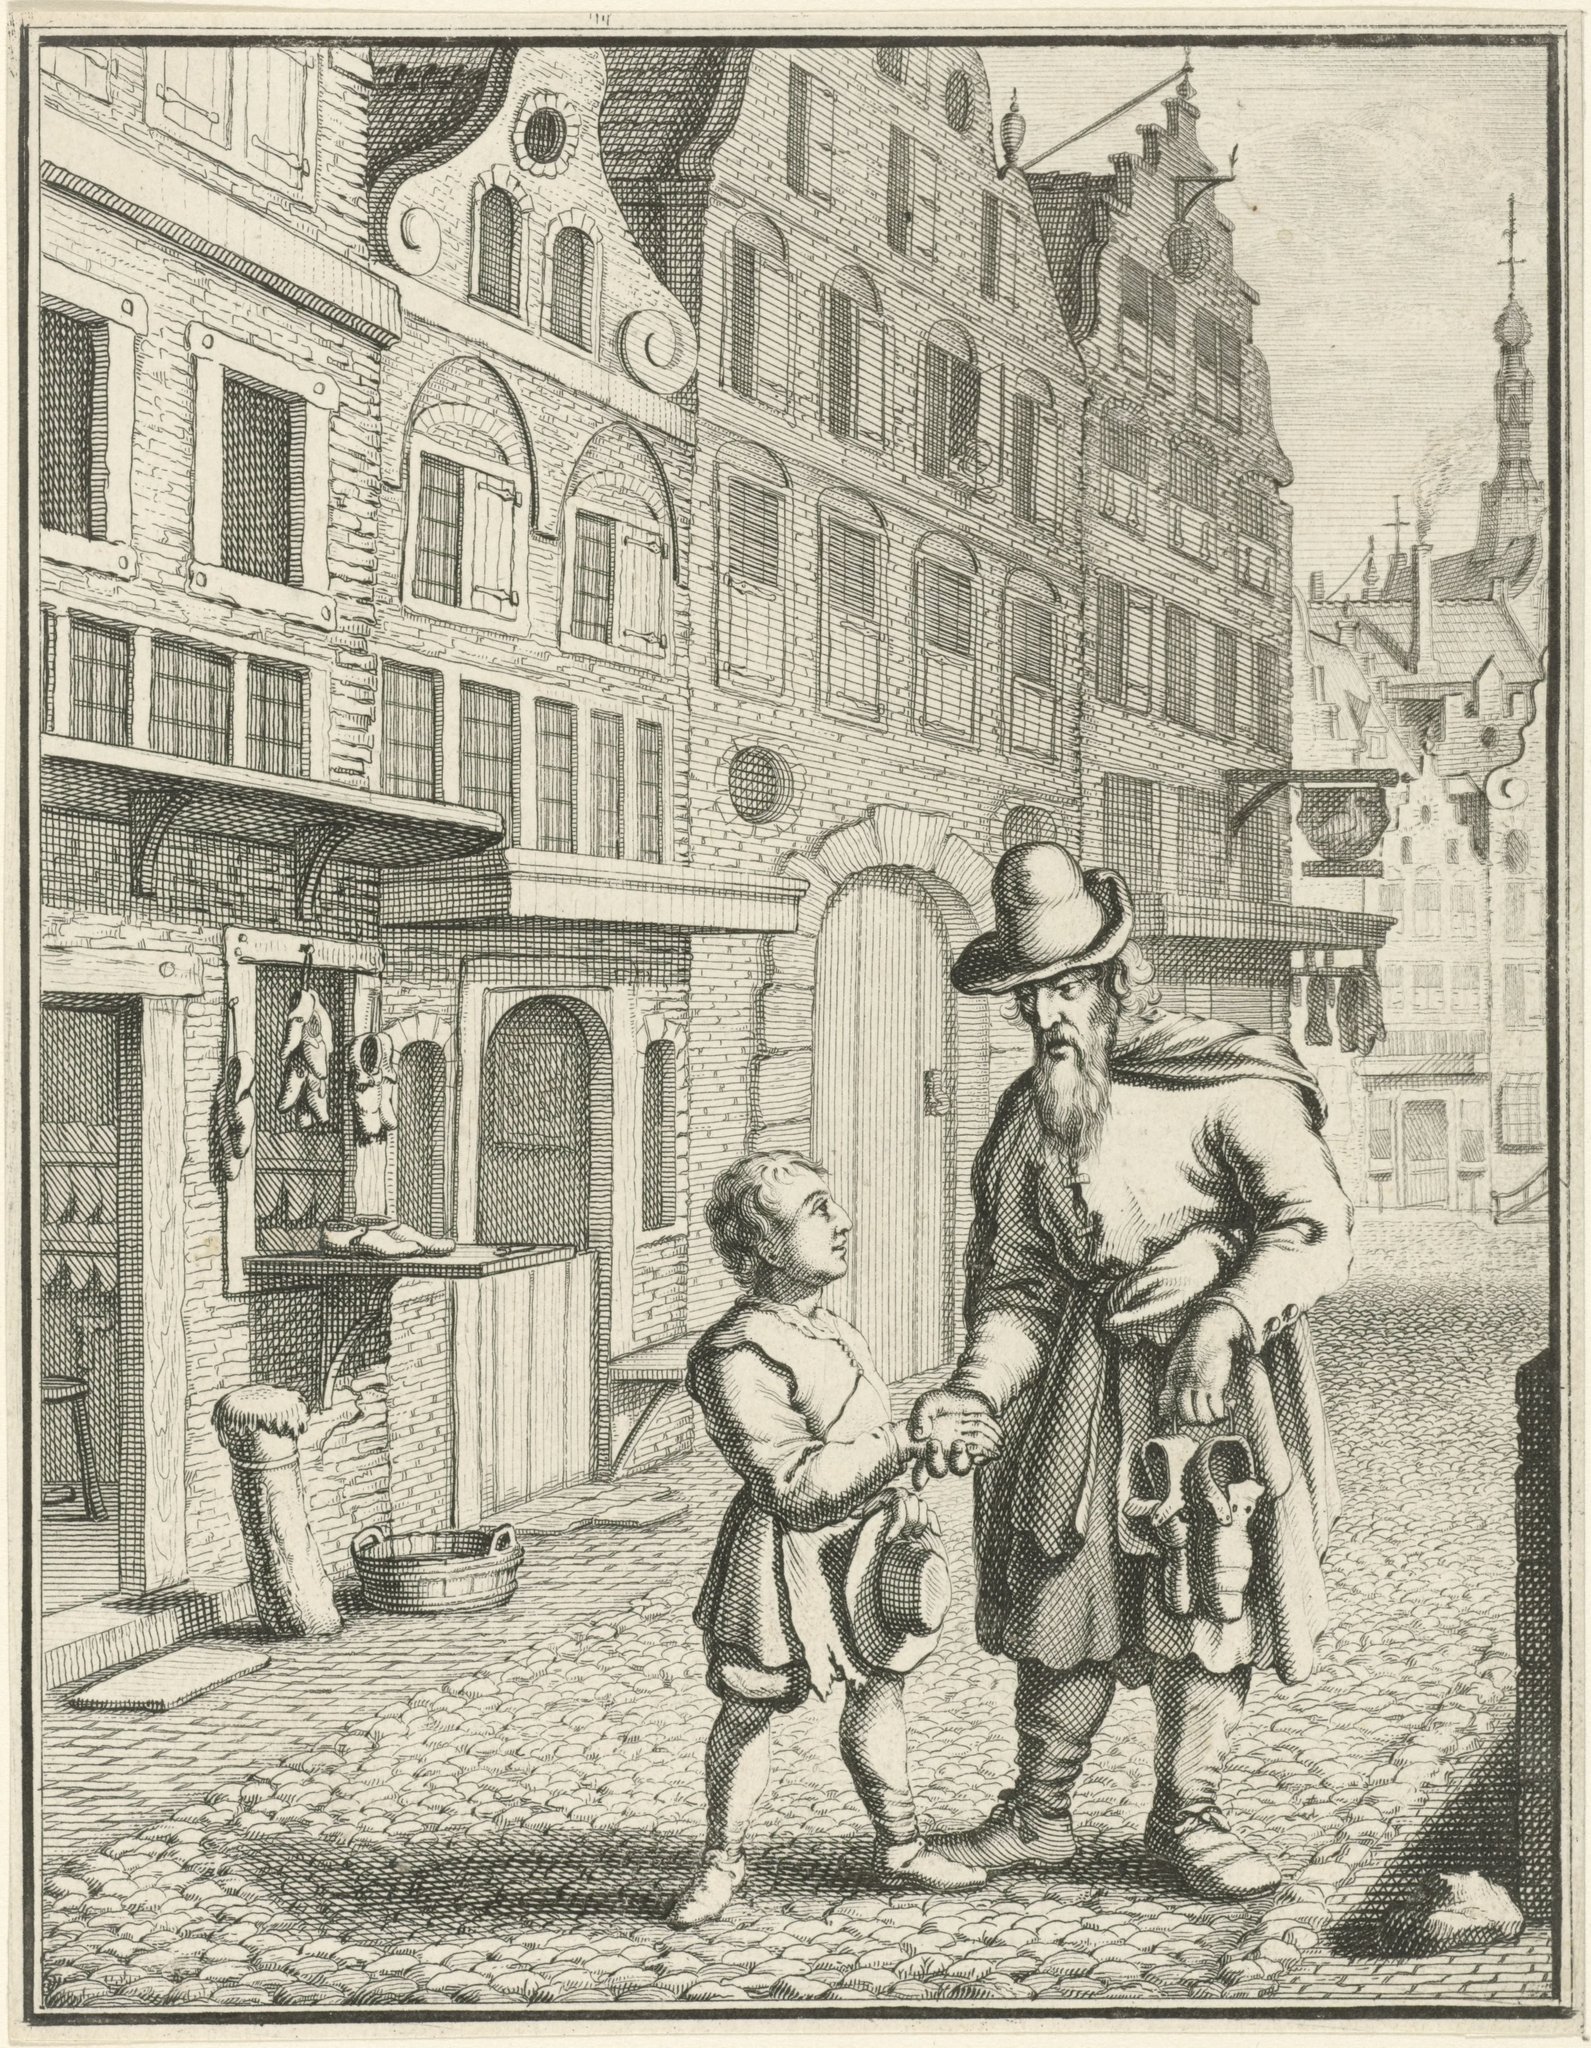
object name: print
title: Jakob Böhme ontmoet een man voor de schoenmakerij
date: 1686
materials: paper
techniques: engraving, etching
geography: amsterdam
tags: village street, shoe-maker, cobbler, gripping someone by the hand or the wrist; clasped hands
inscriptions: collector's mark: Lugt 2228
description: Jakob Böhme, leerjongen in een schoenmakerij, heeft op straat een gesprek met een vreemdeling, die hem een goddelijke toekomst voorspelt. Jakob Böhme werd bekend als mysticus en theosoof.